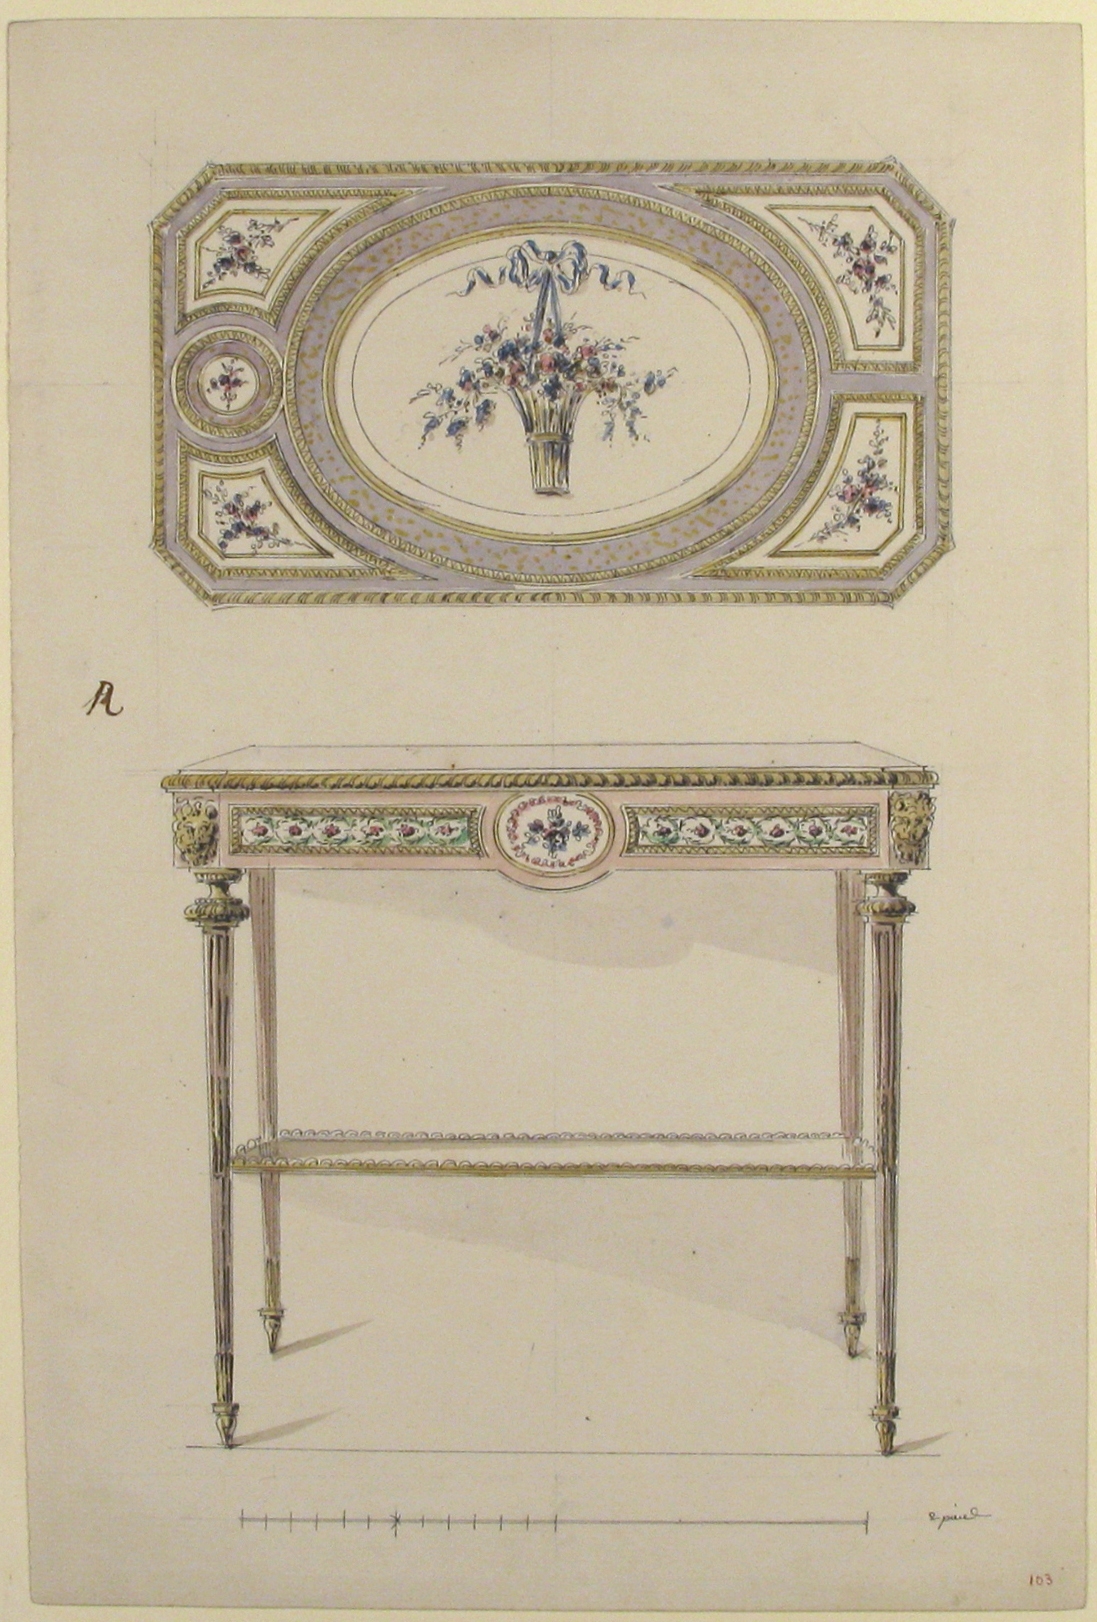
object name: drawing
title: Design for a Table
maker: anonymous, french, 18th century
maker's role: artist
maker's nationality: french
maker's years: 1700-1800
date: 1770-1785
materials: ink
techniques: brush, pen, wash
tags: flowers,tables